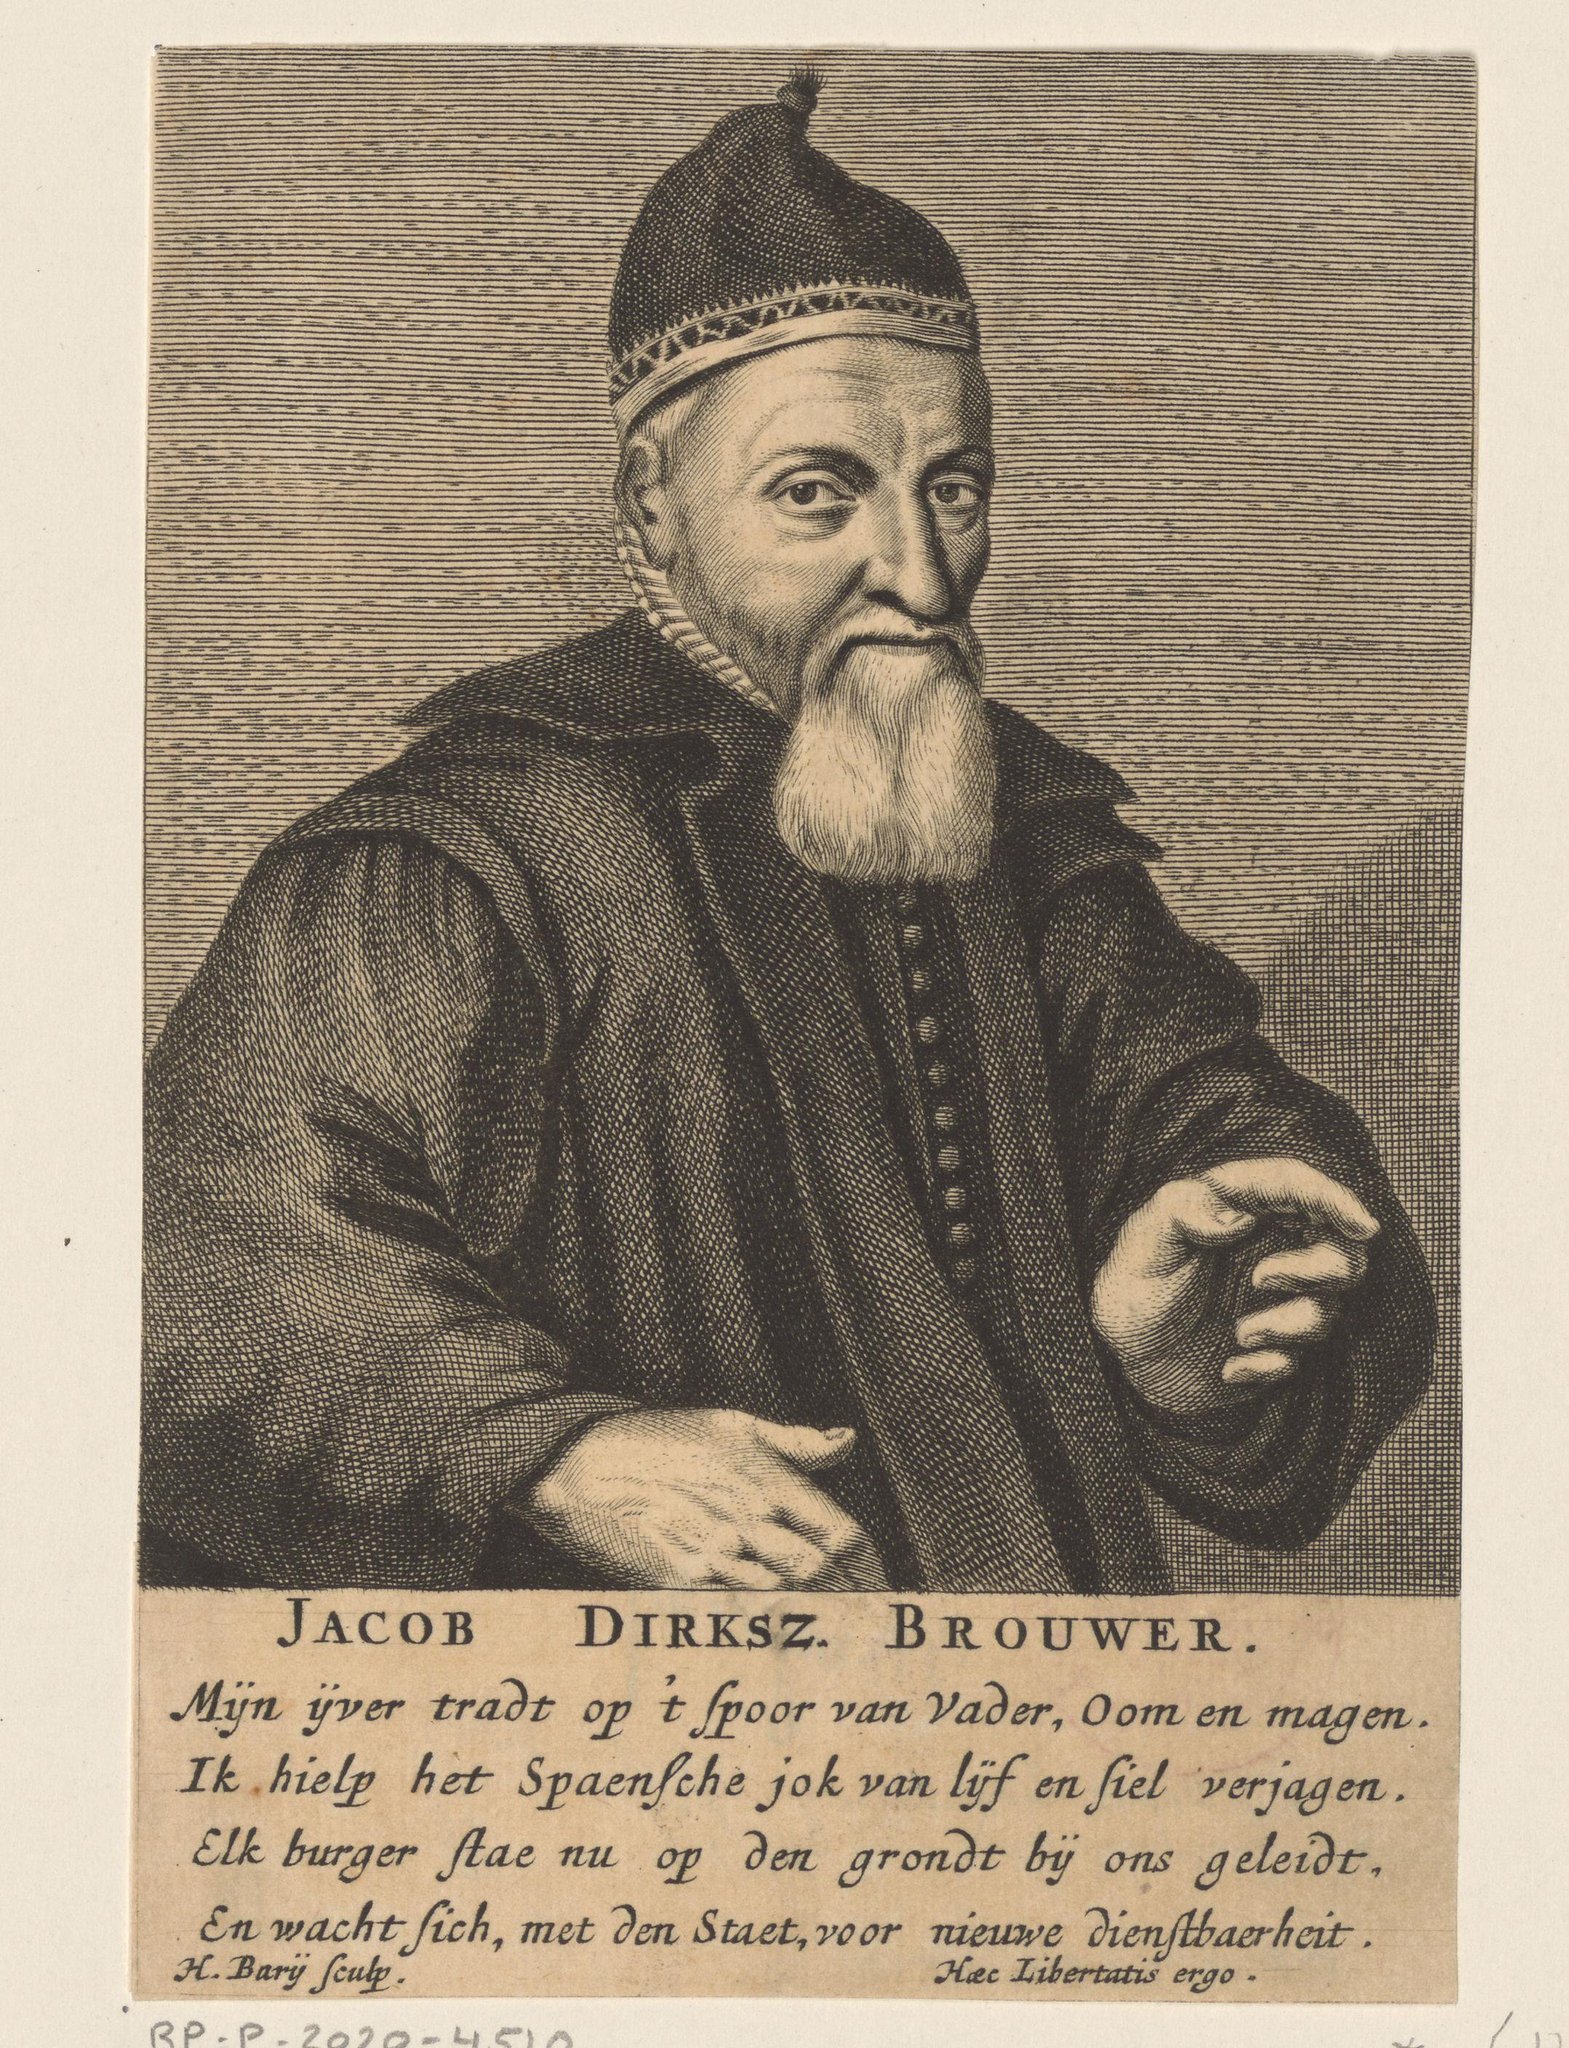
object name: print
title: Portret van Jacob Dirksz. Brouwer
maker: hendrik bary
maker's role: draughtsman, print maker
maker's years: 1640-1707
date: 1666-1747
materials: paper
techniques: engraving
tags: historical persons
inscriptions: collector's mark: Lugt 240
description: Prent uit: Brandt, Geeraert. Historie der vermaerde zee- en koop-stadt Enkhuisen (...). Enkhuizen: Egbert van den Hoof, 1666. Of uit de tweede druk (Enkhuizen: Jacob Duyn, 1747).